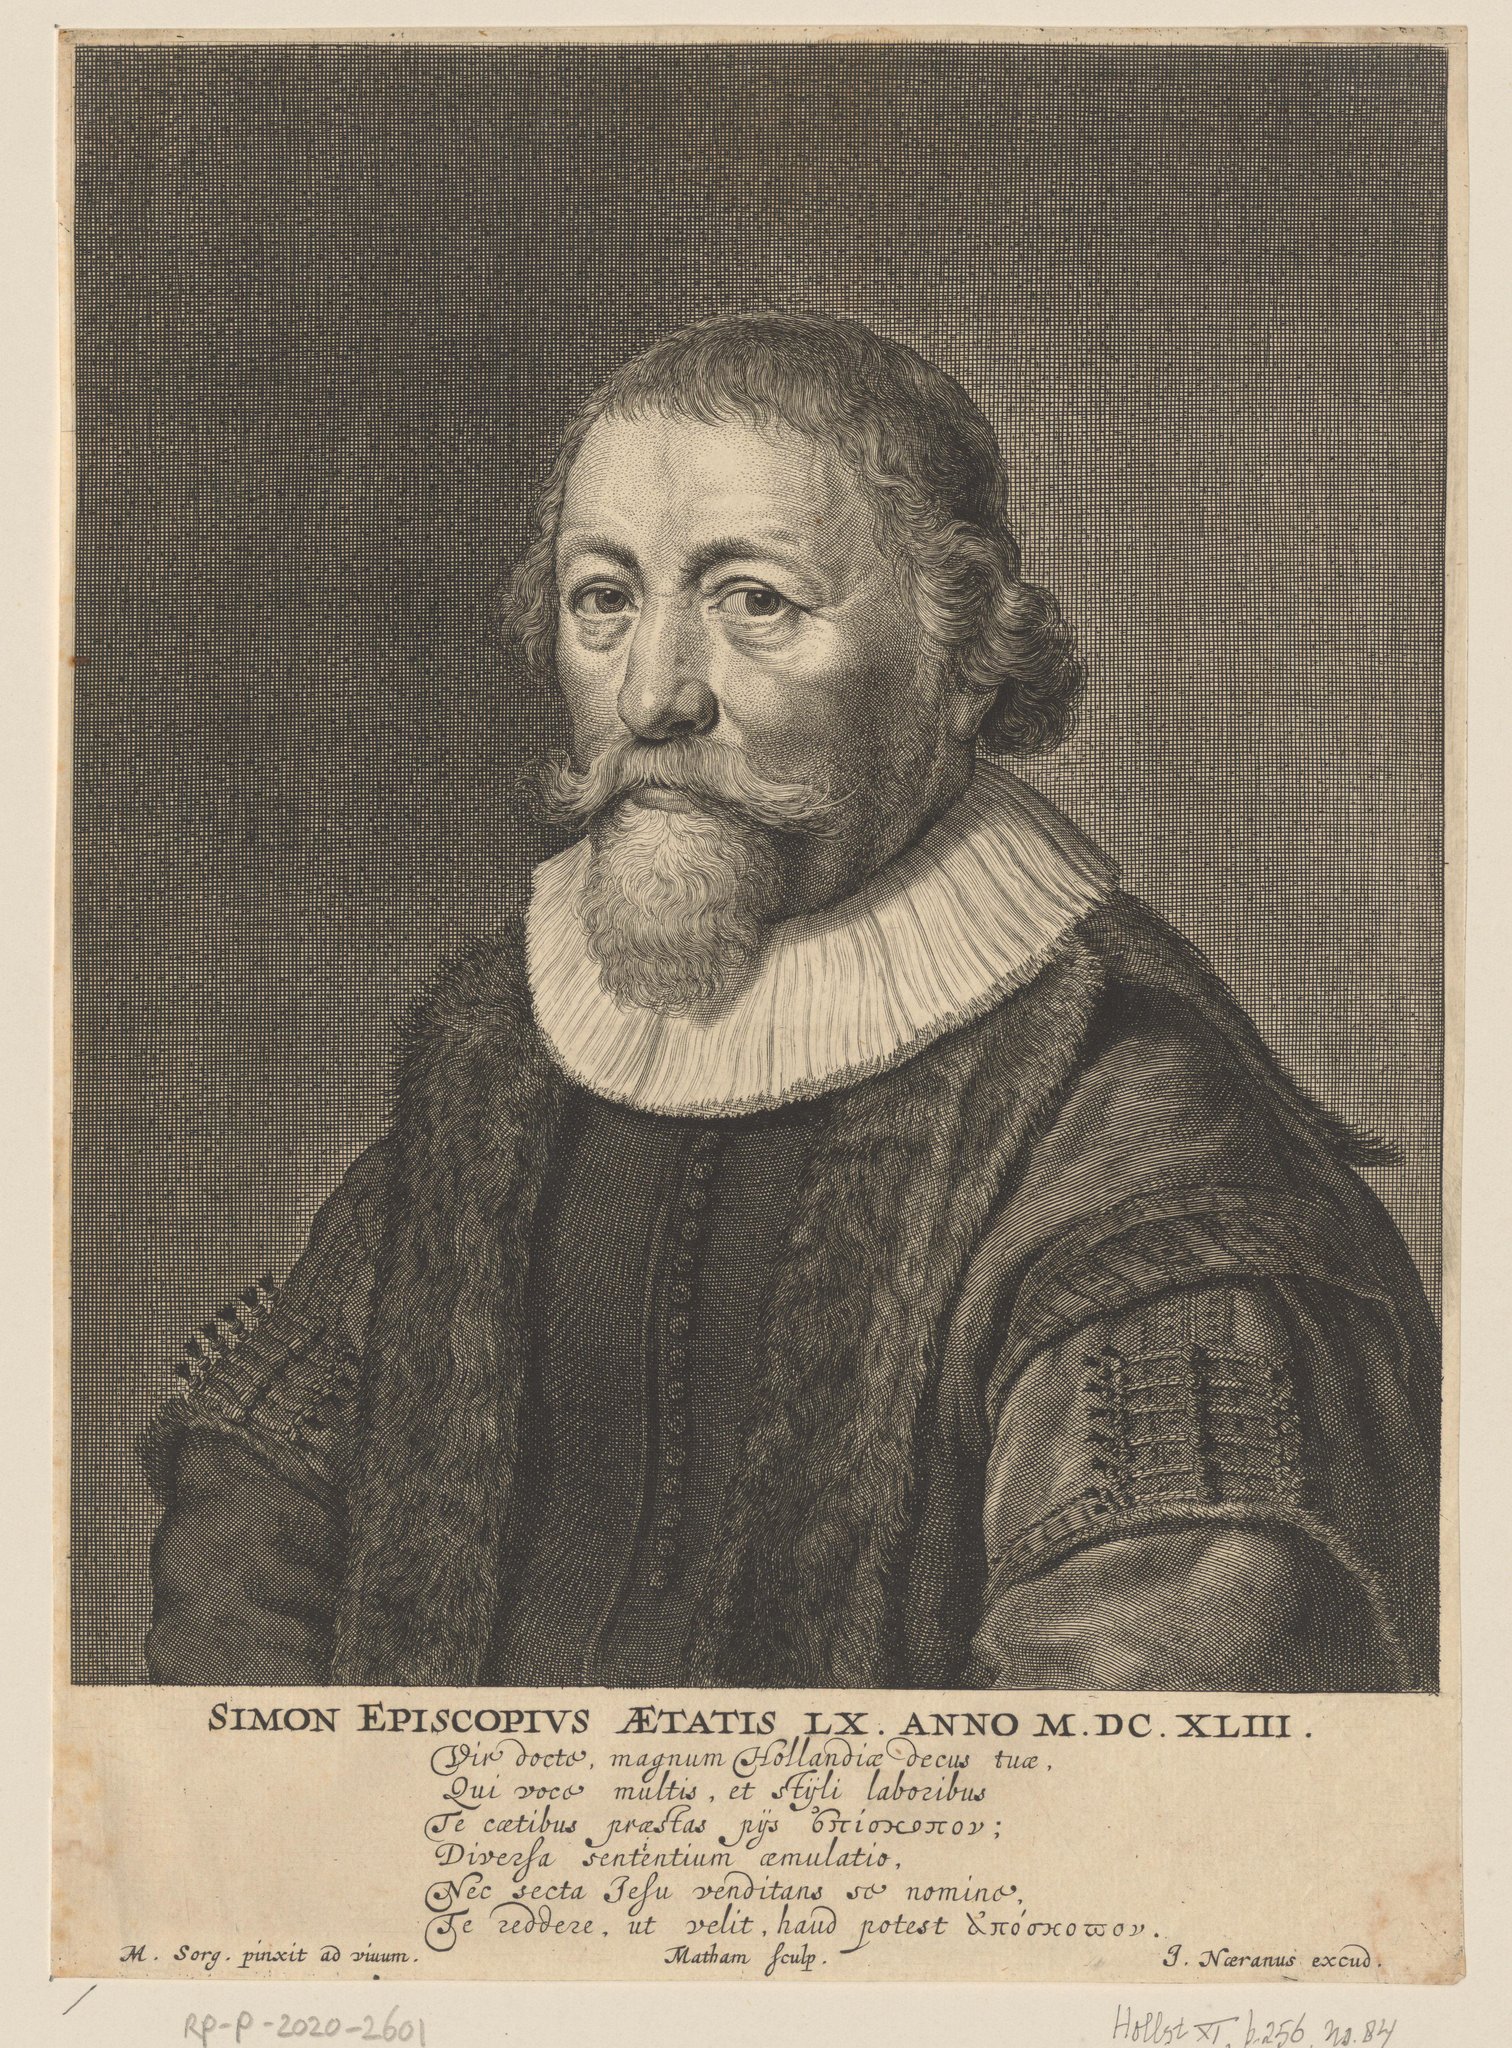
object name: print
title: Portret van Simon Episcopius op 60-jarige leeftijd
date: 1643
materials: paper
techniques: engraving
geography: rotterdam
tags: amsterdam, theologian, historical persons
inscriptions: date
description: Met zesregelig vers in het Latijn onder het portret.